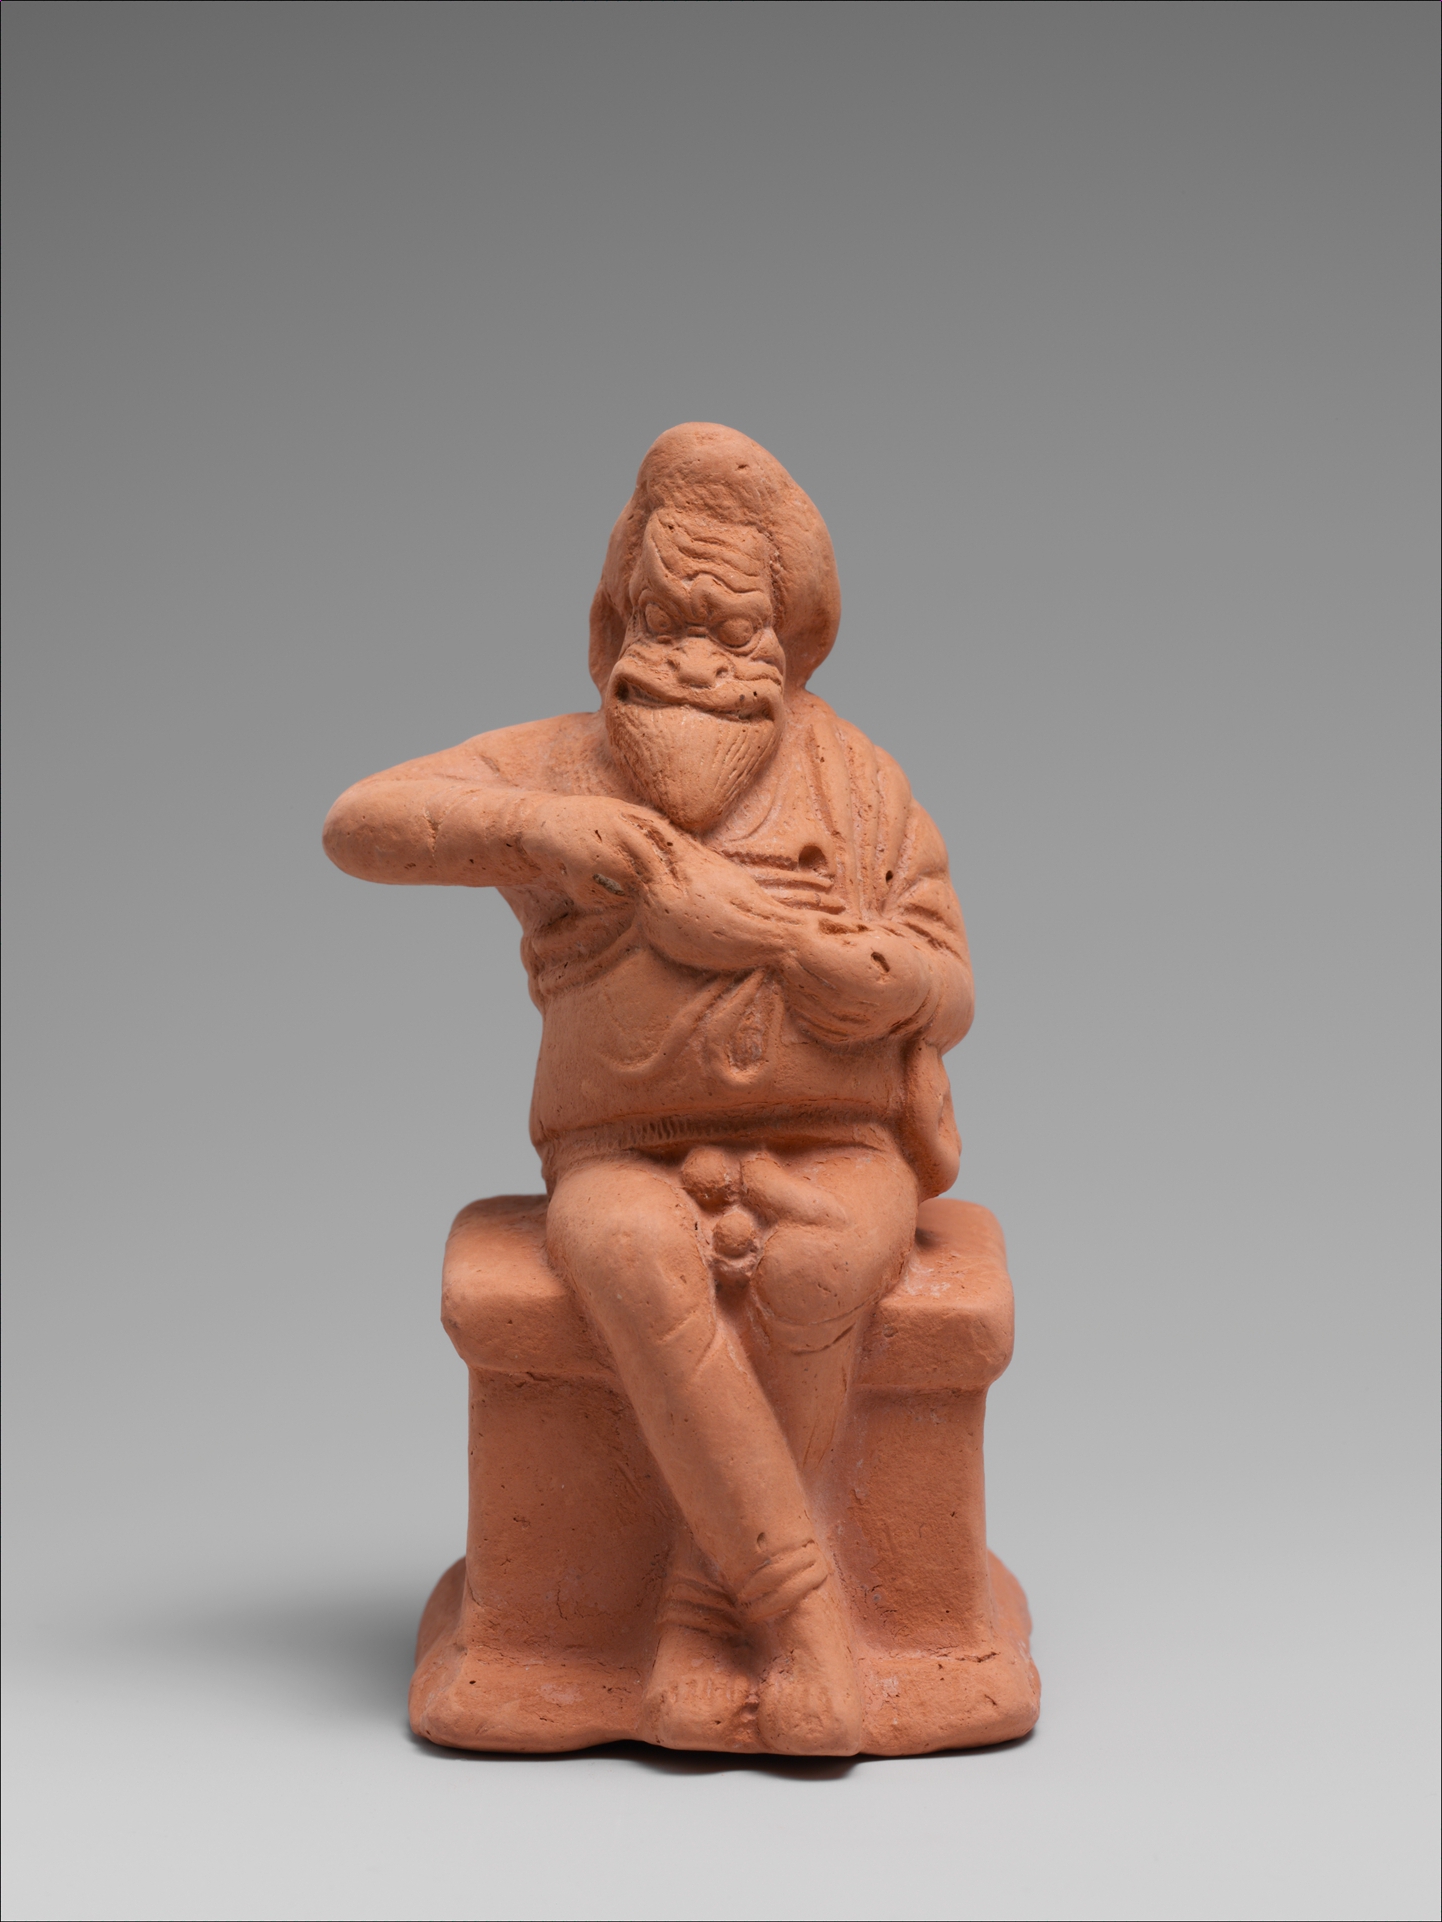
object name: statuette of an actor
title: Terracotta statuette of an actor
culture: greek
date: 434-368 BCE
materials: terracotta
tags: men,actors